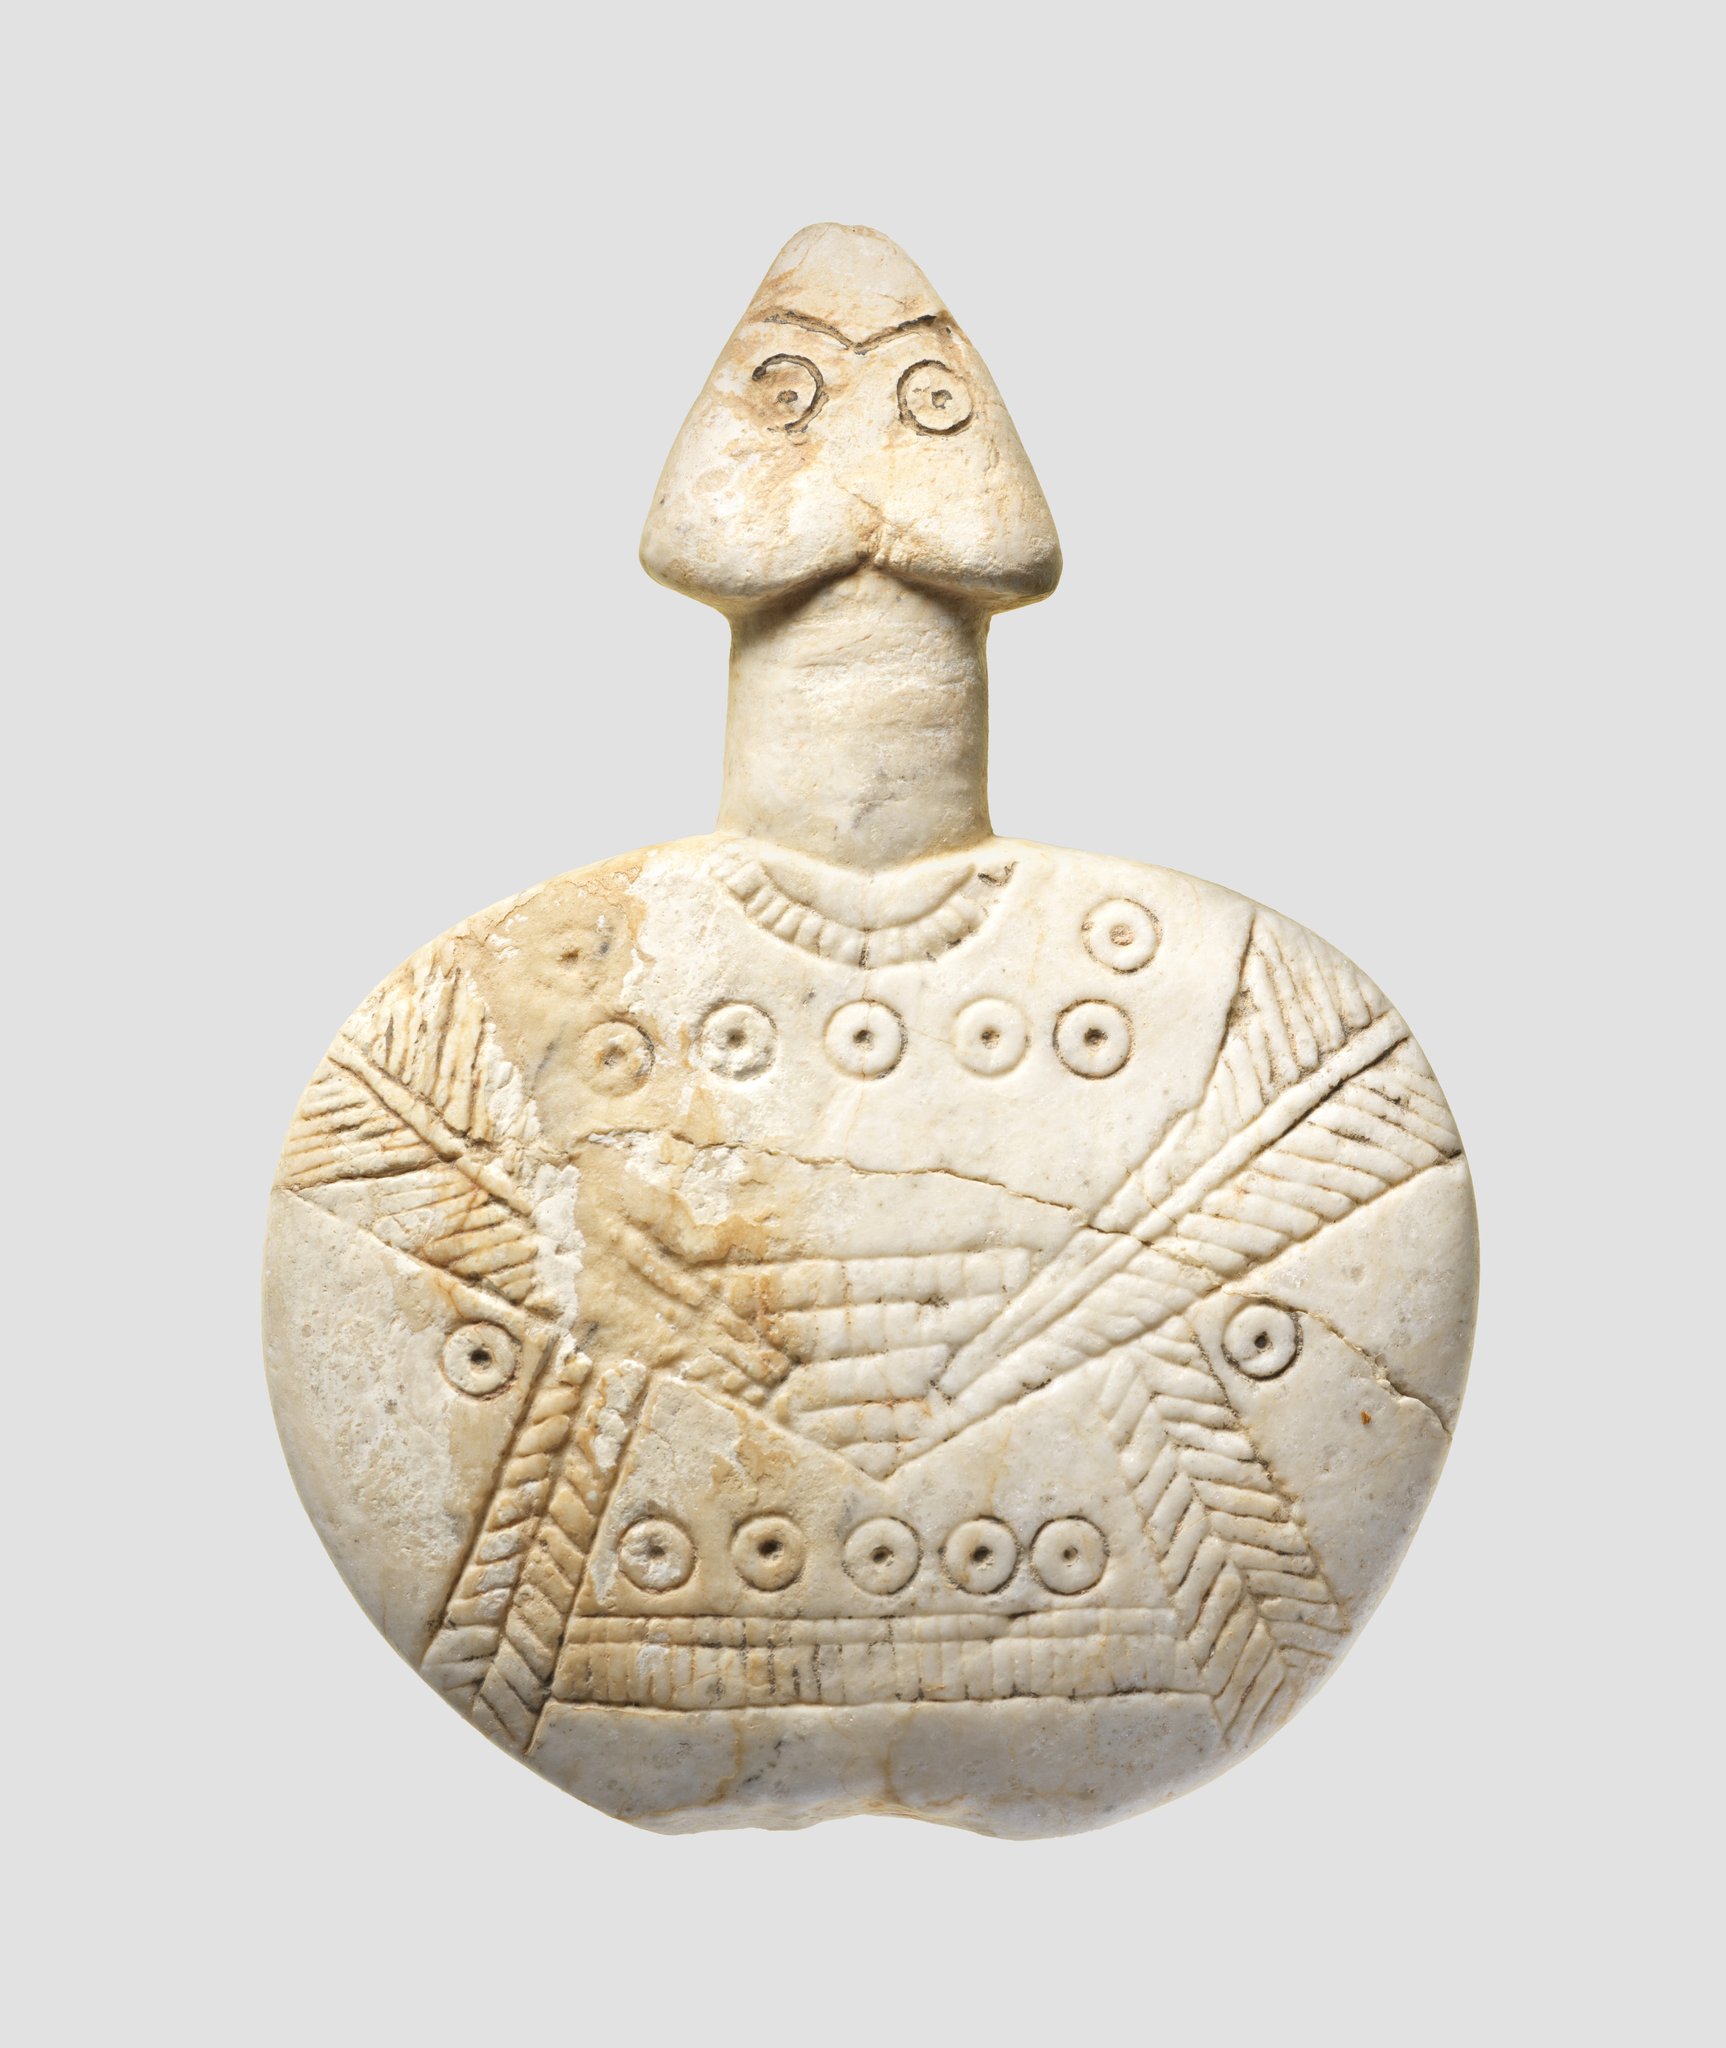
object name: sculpture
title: Disc-shaped figure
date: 2300-2000 BCE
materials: alabaster, gypsum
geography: central anatolia